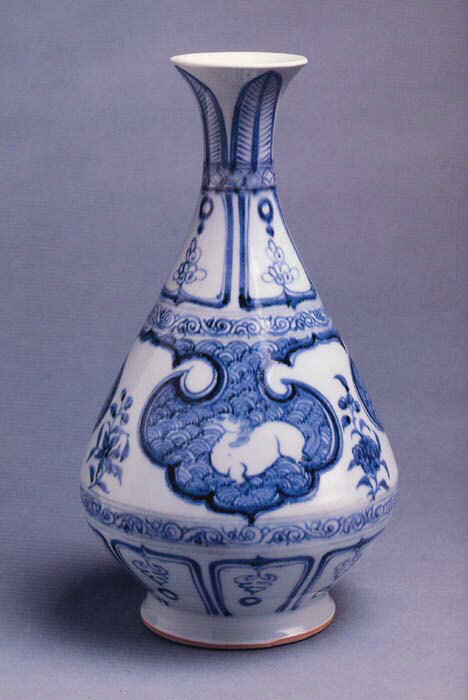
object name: vase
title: Vase with horses in waves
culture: chinese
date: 1334-1366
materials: cobalt, glaze, porcelain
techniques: painting